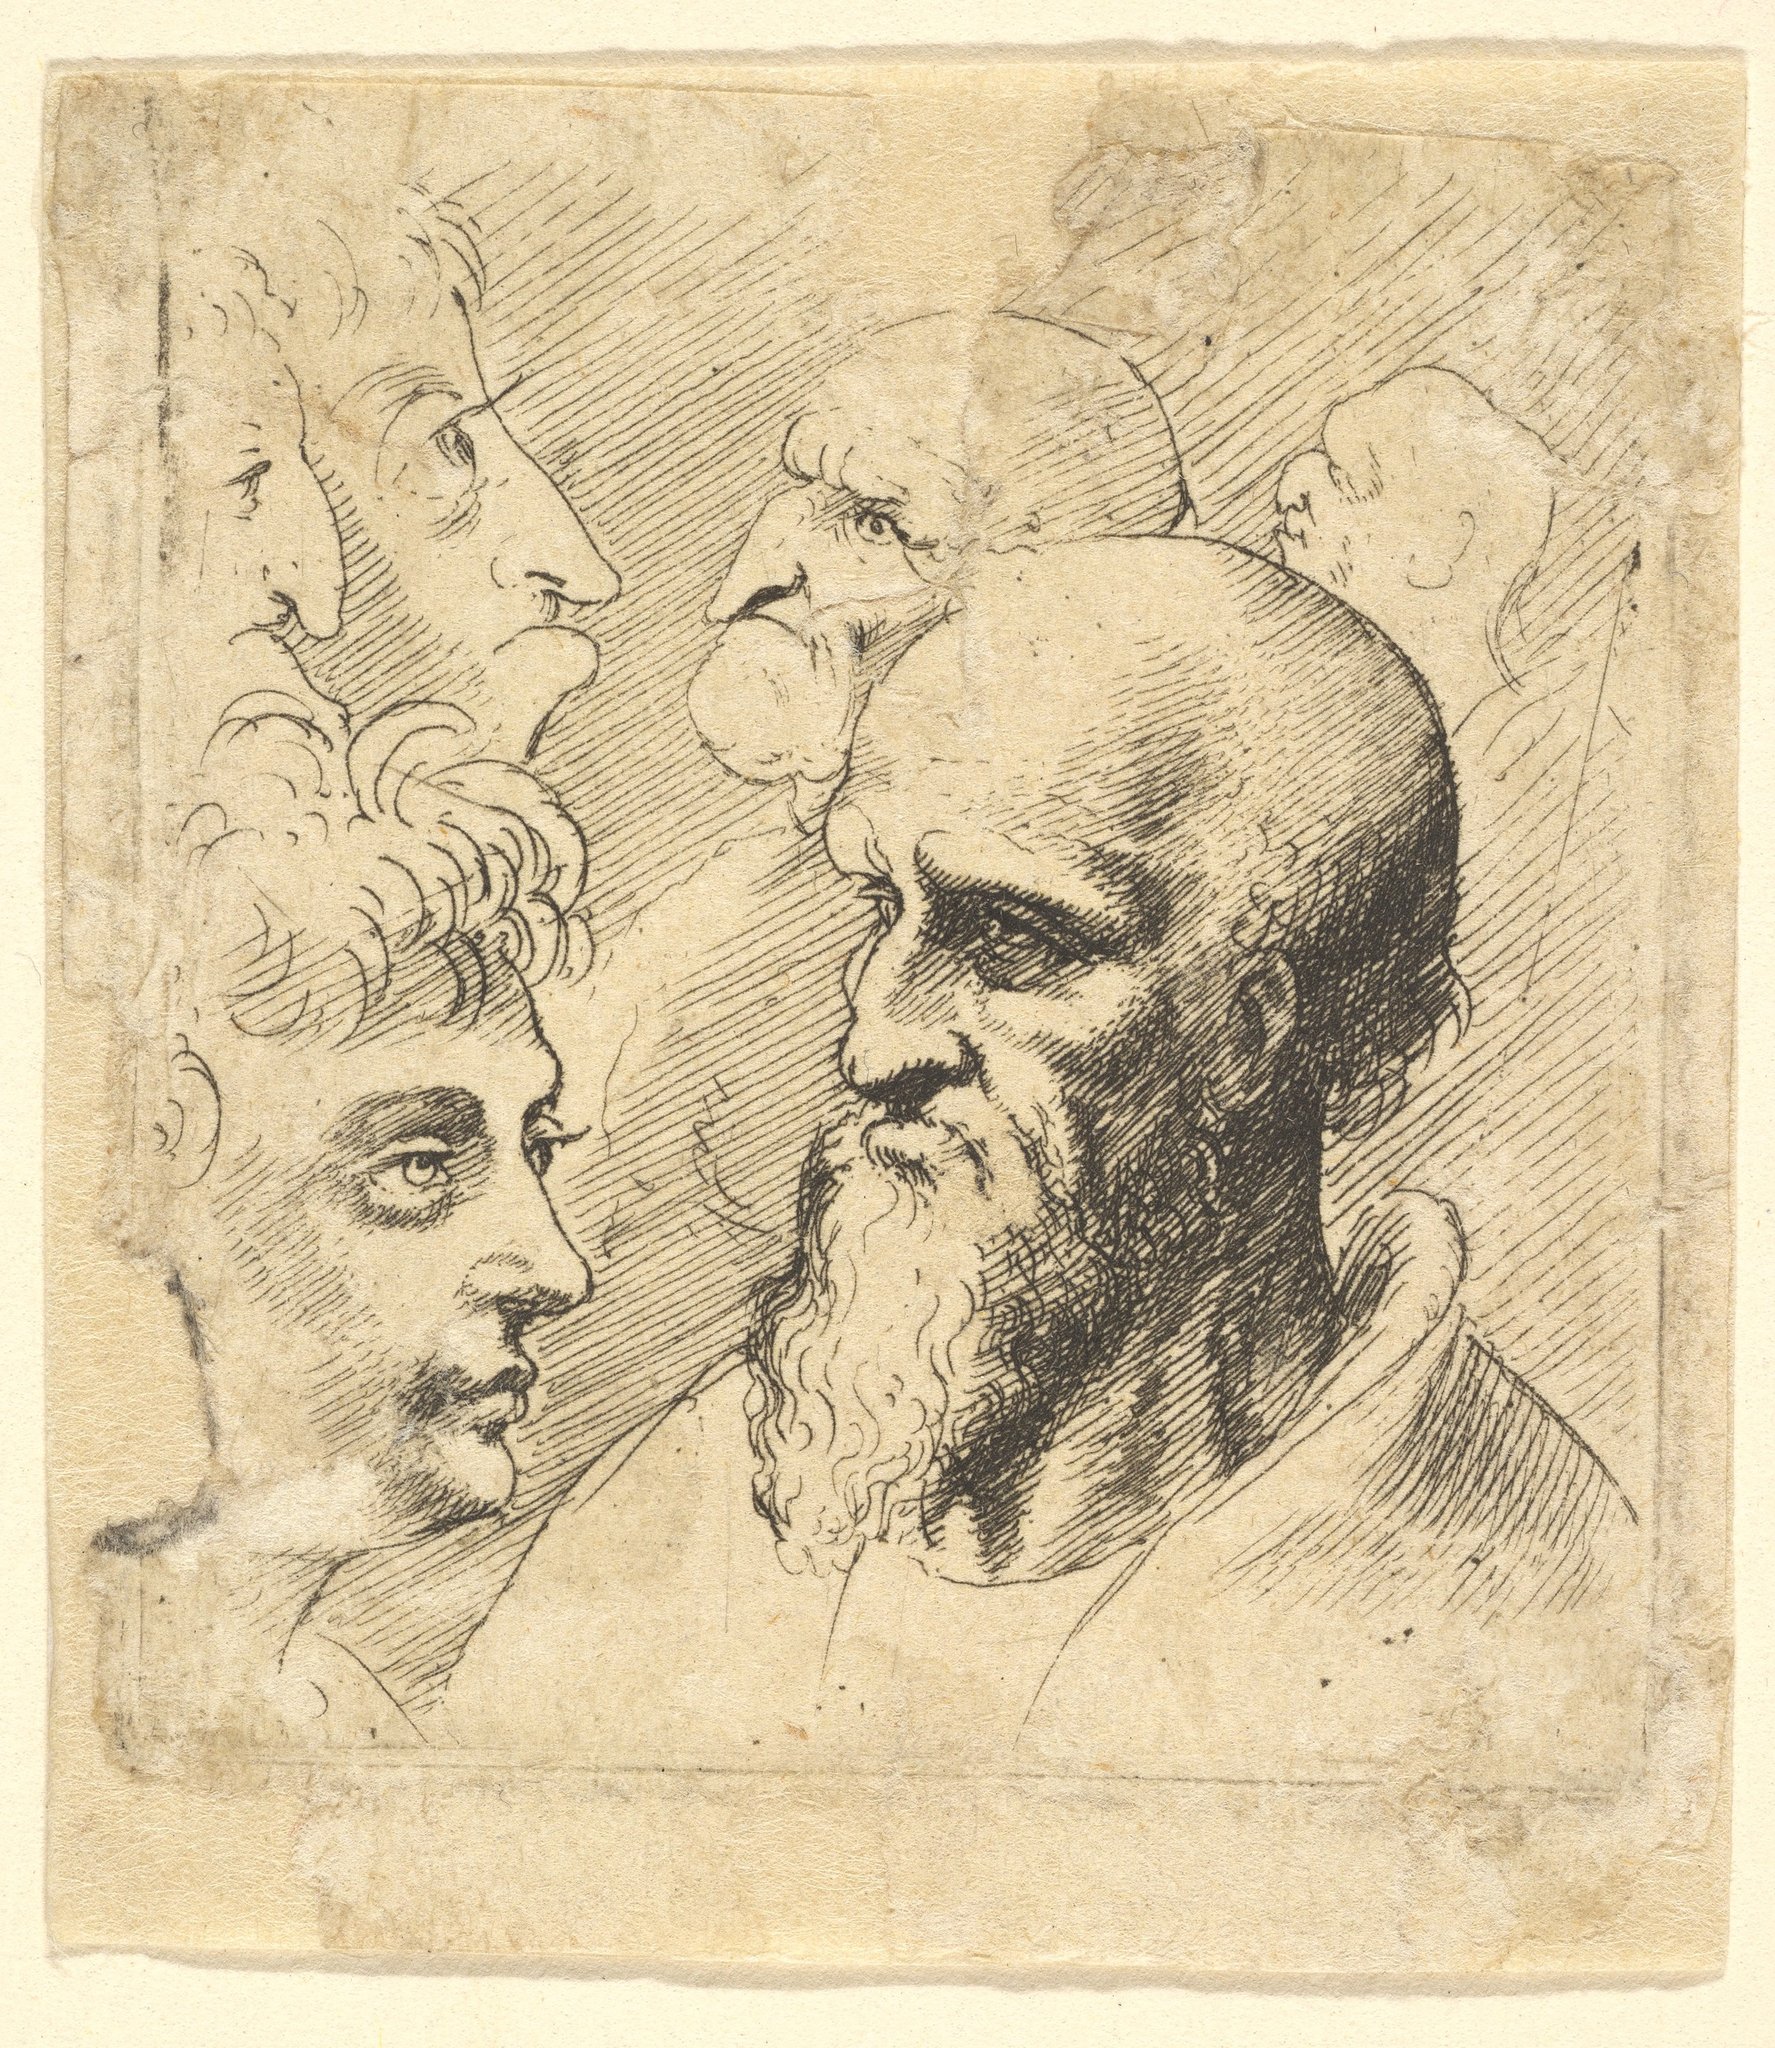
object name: print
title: Title page to Diversae Probae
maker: wenceslaus hollar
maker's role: artist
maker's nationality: bohemian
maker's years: 1607-1677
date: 1645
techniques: etching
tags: men,portraits